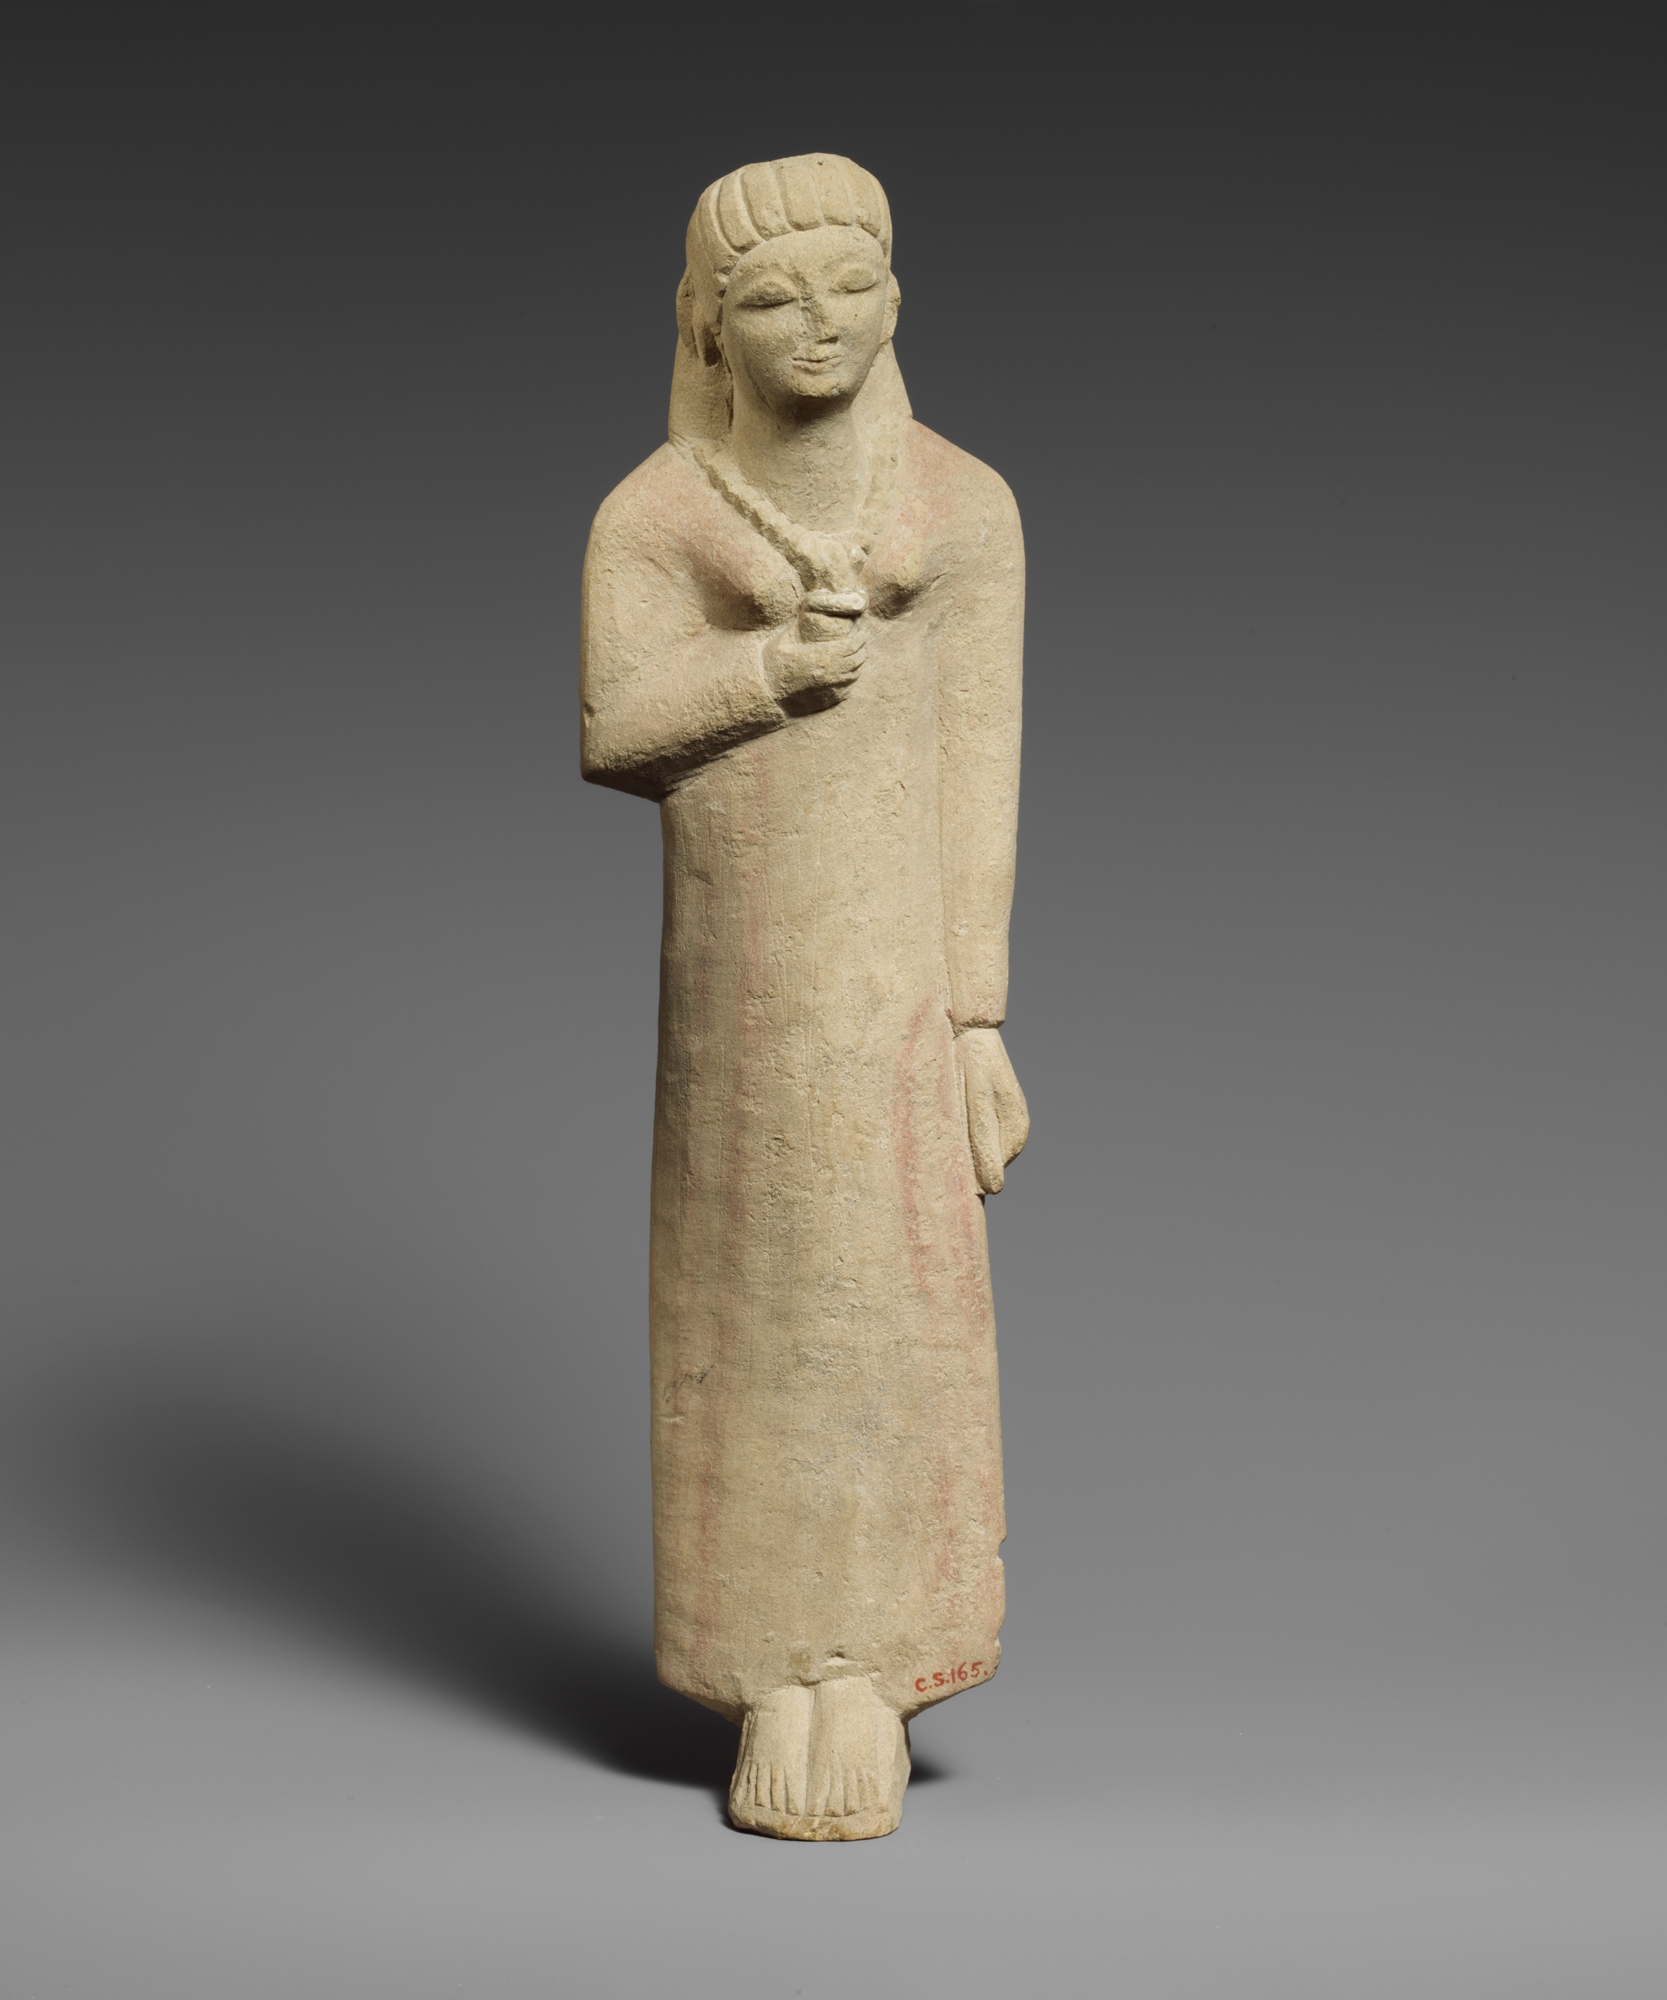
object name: statue of a votary, female, holding a flower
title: Limestone statuette of a female votary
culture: cypriot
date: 550-501 BCE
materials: limestone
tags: women